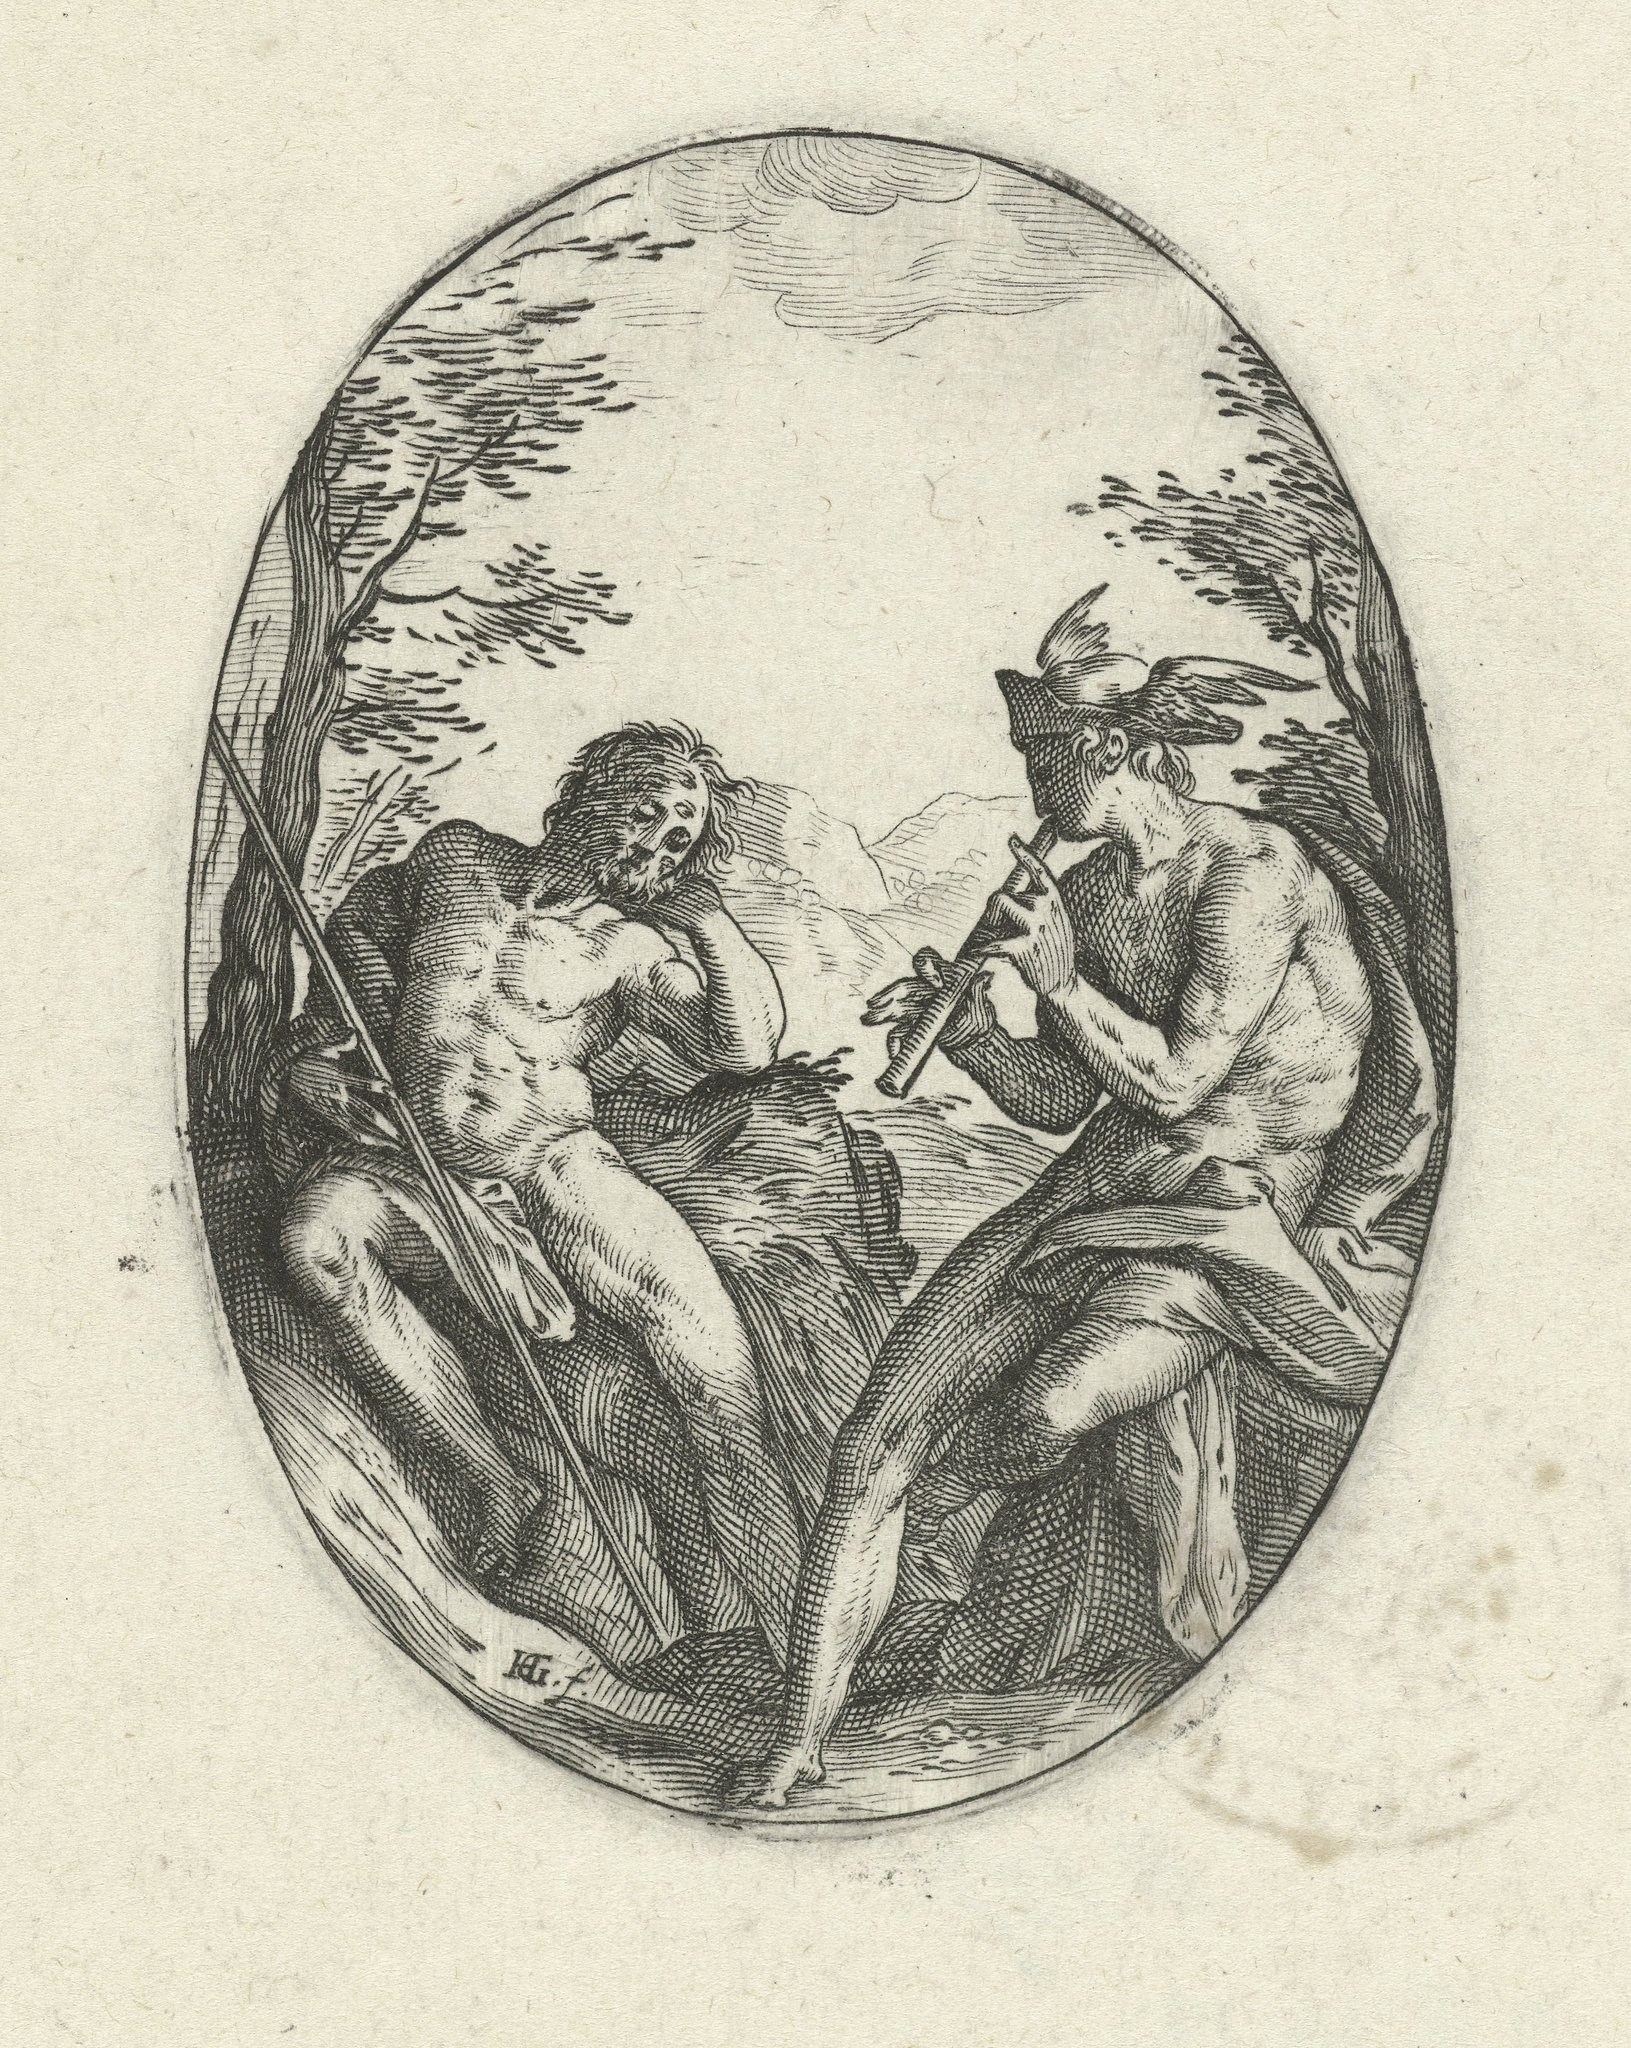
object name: print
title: Argus en Mercurius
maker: hendrick goltzius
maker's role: draughtsman, painter, print maker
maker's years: 1558-1617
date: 1580-1590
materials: paper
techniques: engraving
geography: haarlem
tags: mercury lulls argus into sleep by making music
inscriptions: collector's mark: Lugt 240, monogram: ‘HG. f.’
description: Mercurius speelt Argus met zijn fluit in slaap. Voorstelling in ovaal.